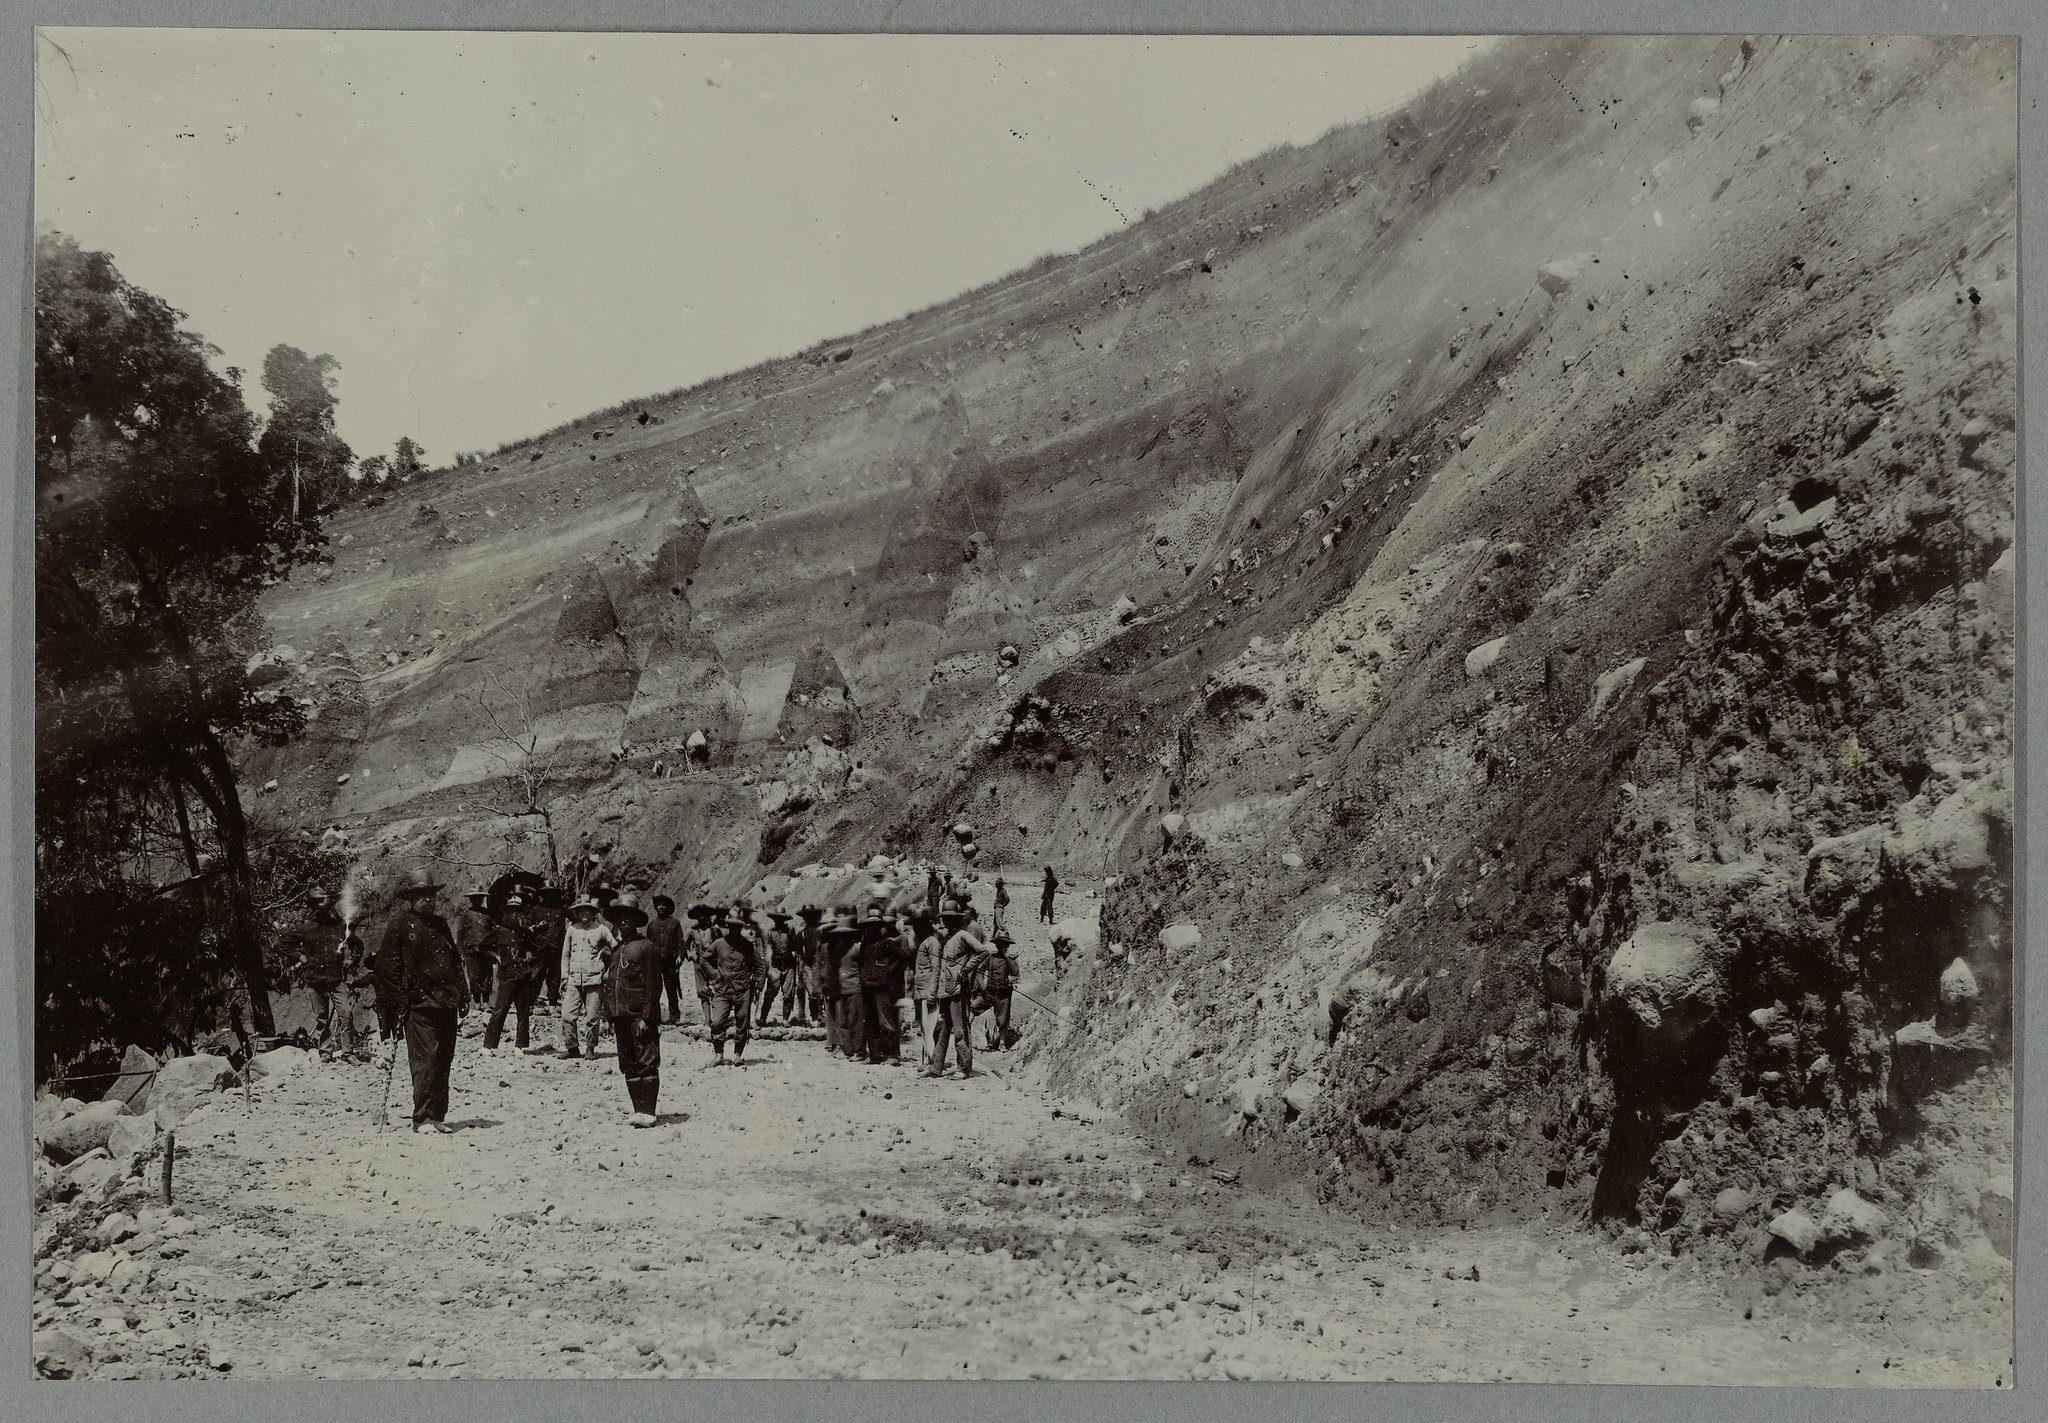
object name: photograph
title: Aanleg van de weg langs een helling van de Woih ni Tanggo Besi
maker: Anonymous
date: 1903-1913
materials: photographic support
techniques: photography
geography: north sumatra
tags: arnhem, albertus dominicus laman trip, building activities, traffic by road or path with motor-vehicle, landscapes in tropical and sub-tropical regions, road, path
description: Na de expedities naar de Gajo- en Alaslanden o.l.v. Van Daalen (eerste tocht in 1901), werd hij in 1903 belast met voorbereiding van permanente vestiging van Nederlands gezag. Aanleg van een weg van de Noordkust naar het binnenland was hierbij van groot belang. Deze zgn. Gajoweg werd aangelegd tussen 1903 en 1914, van Bireuen aan de kust naar Takinguen aan het bergmeer Danau Lauttawar, totale lente 104 km.